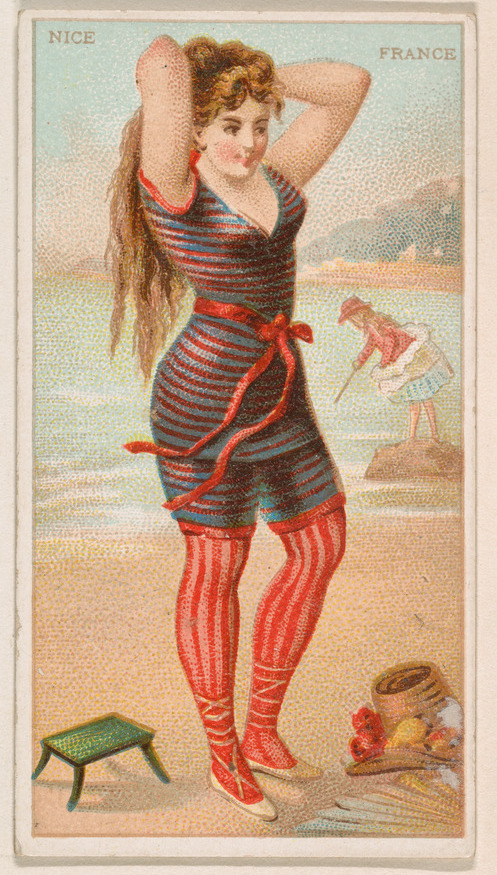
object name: print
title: Nice, France, from the Surf Beauties series (N232), issued by Kinney Bros.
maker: kinney brothers tobacco company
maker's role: publisher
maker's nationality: american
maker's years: 1869-2011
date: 1889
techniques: color lithograph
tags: women,sports